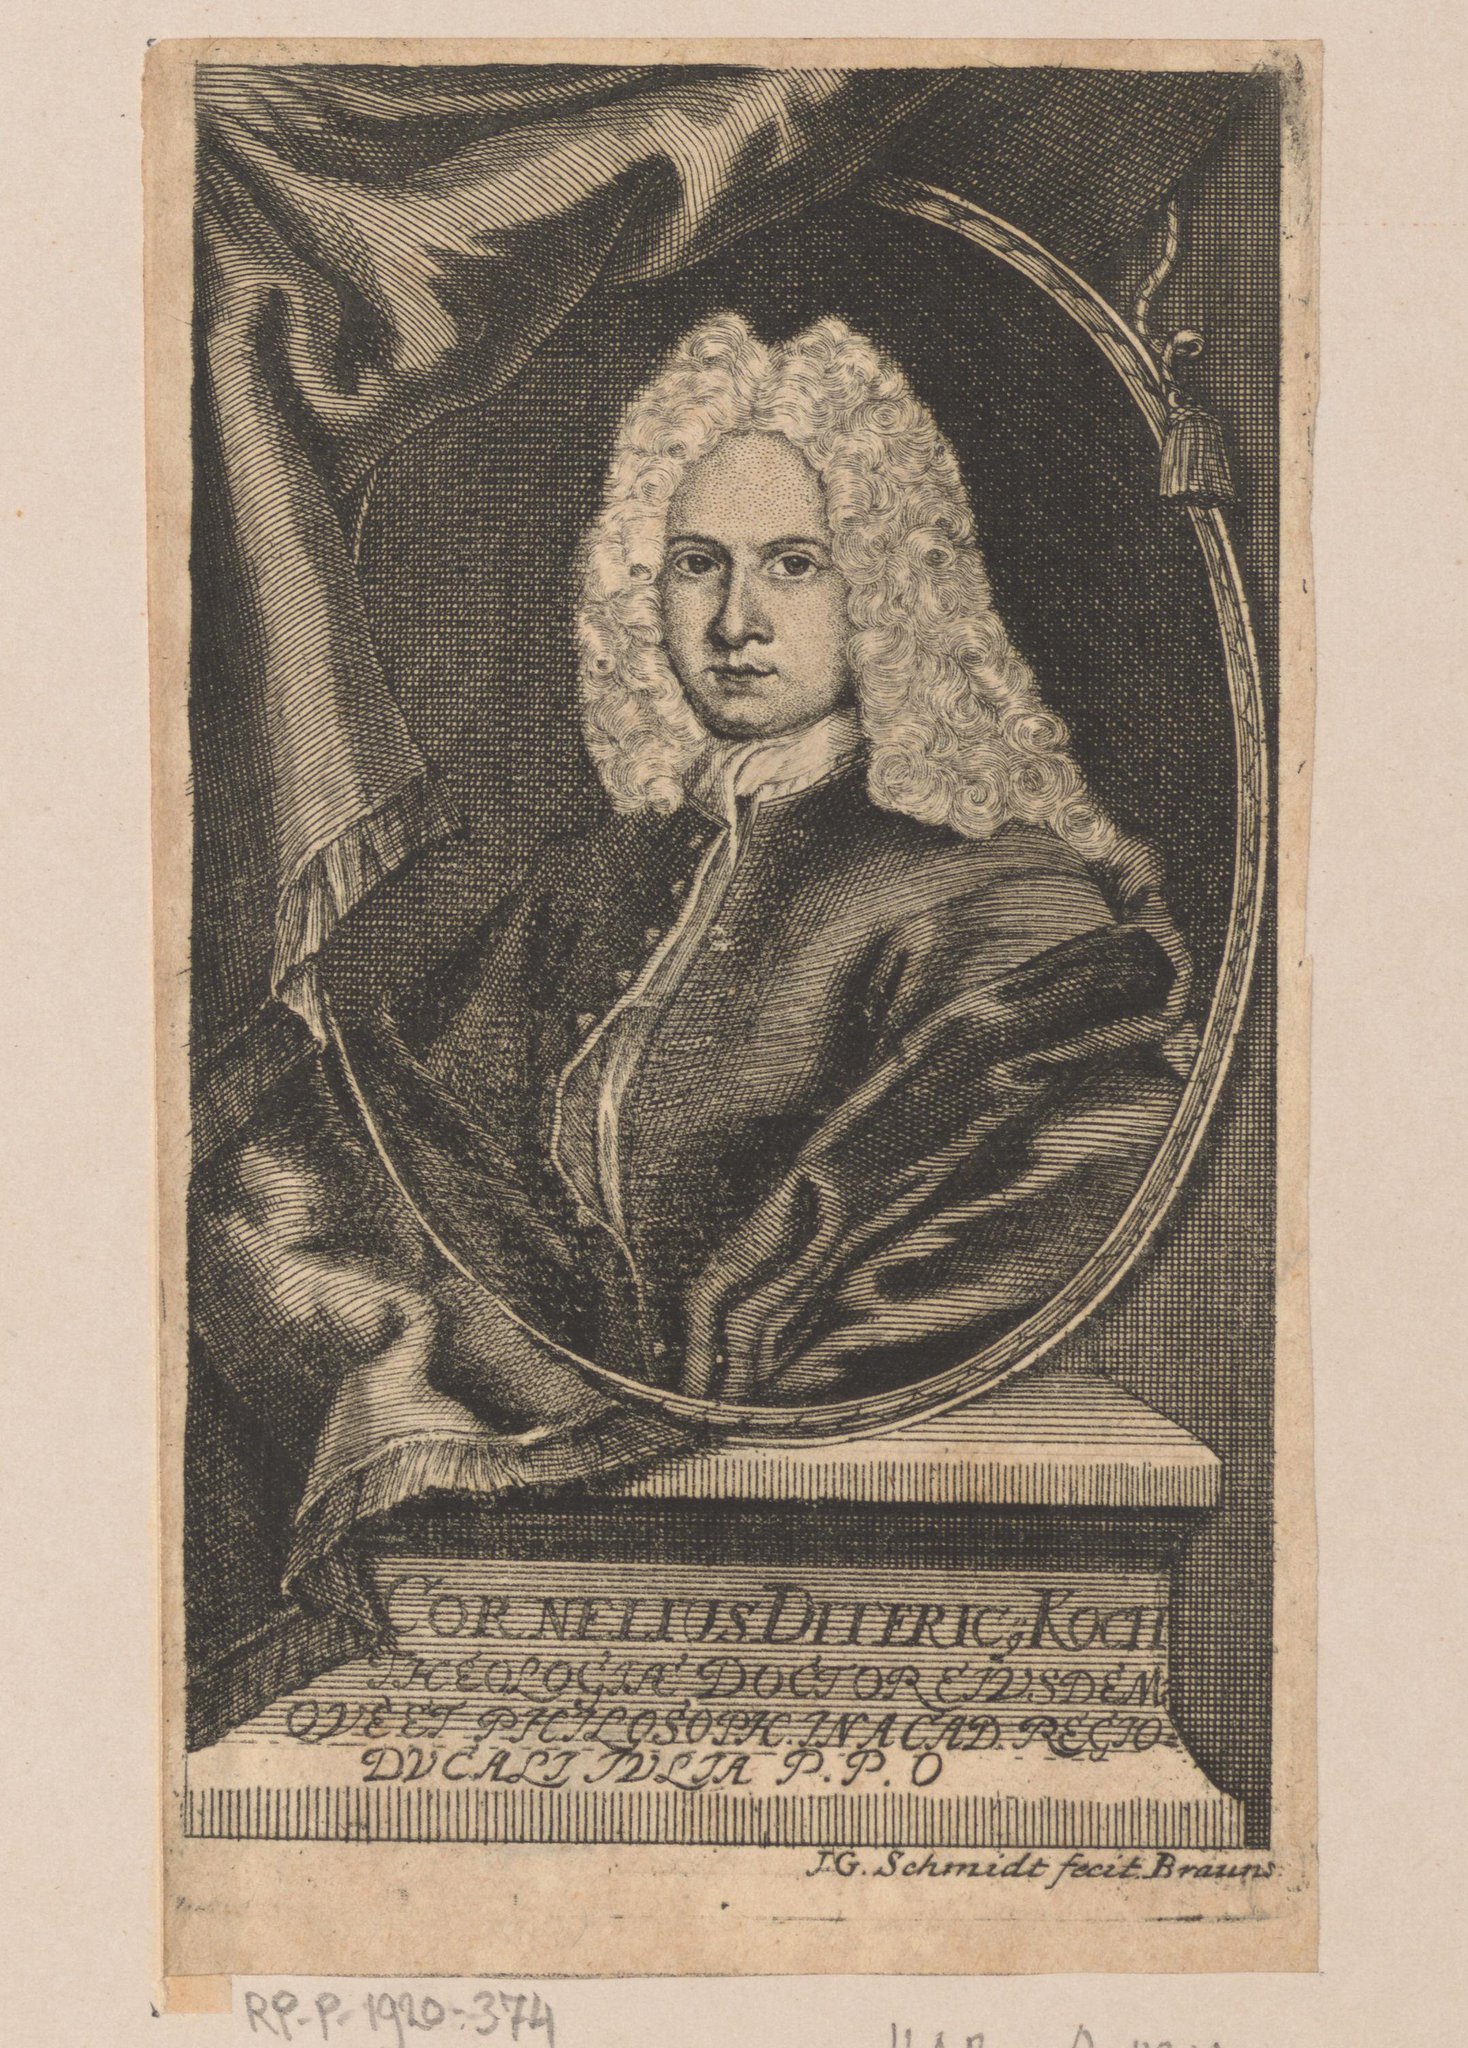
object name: print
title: Portret van Cornelius Dietrich Koch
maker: johann georg schmidt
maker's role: print maker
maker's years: 1694-1767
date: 1704-1765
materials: paper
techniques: engraving, etching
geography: braunschweig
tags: historical persons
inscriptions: collector's mark: Lugt 2228